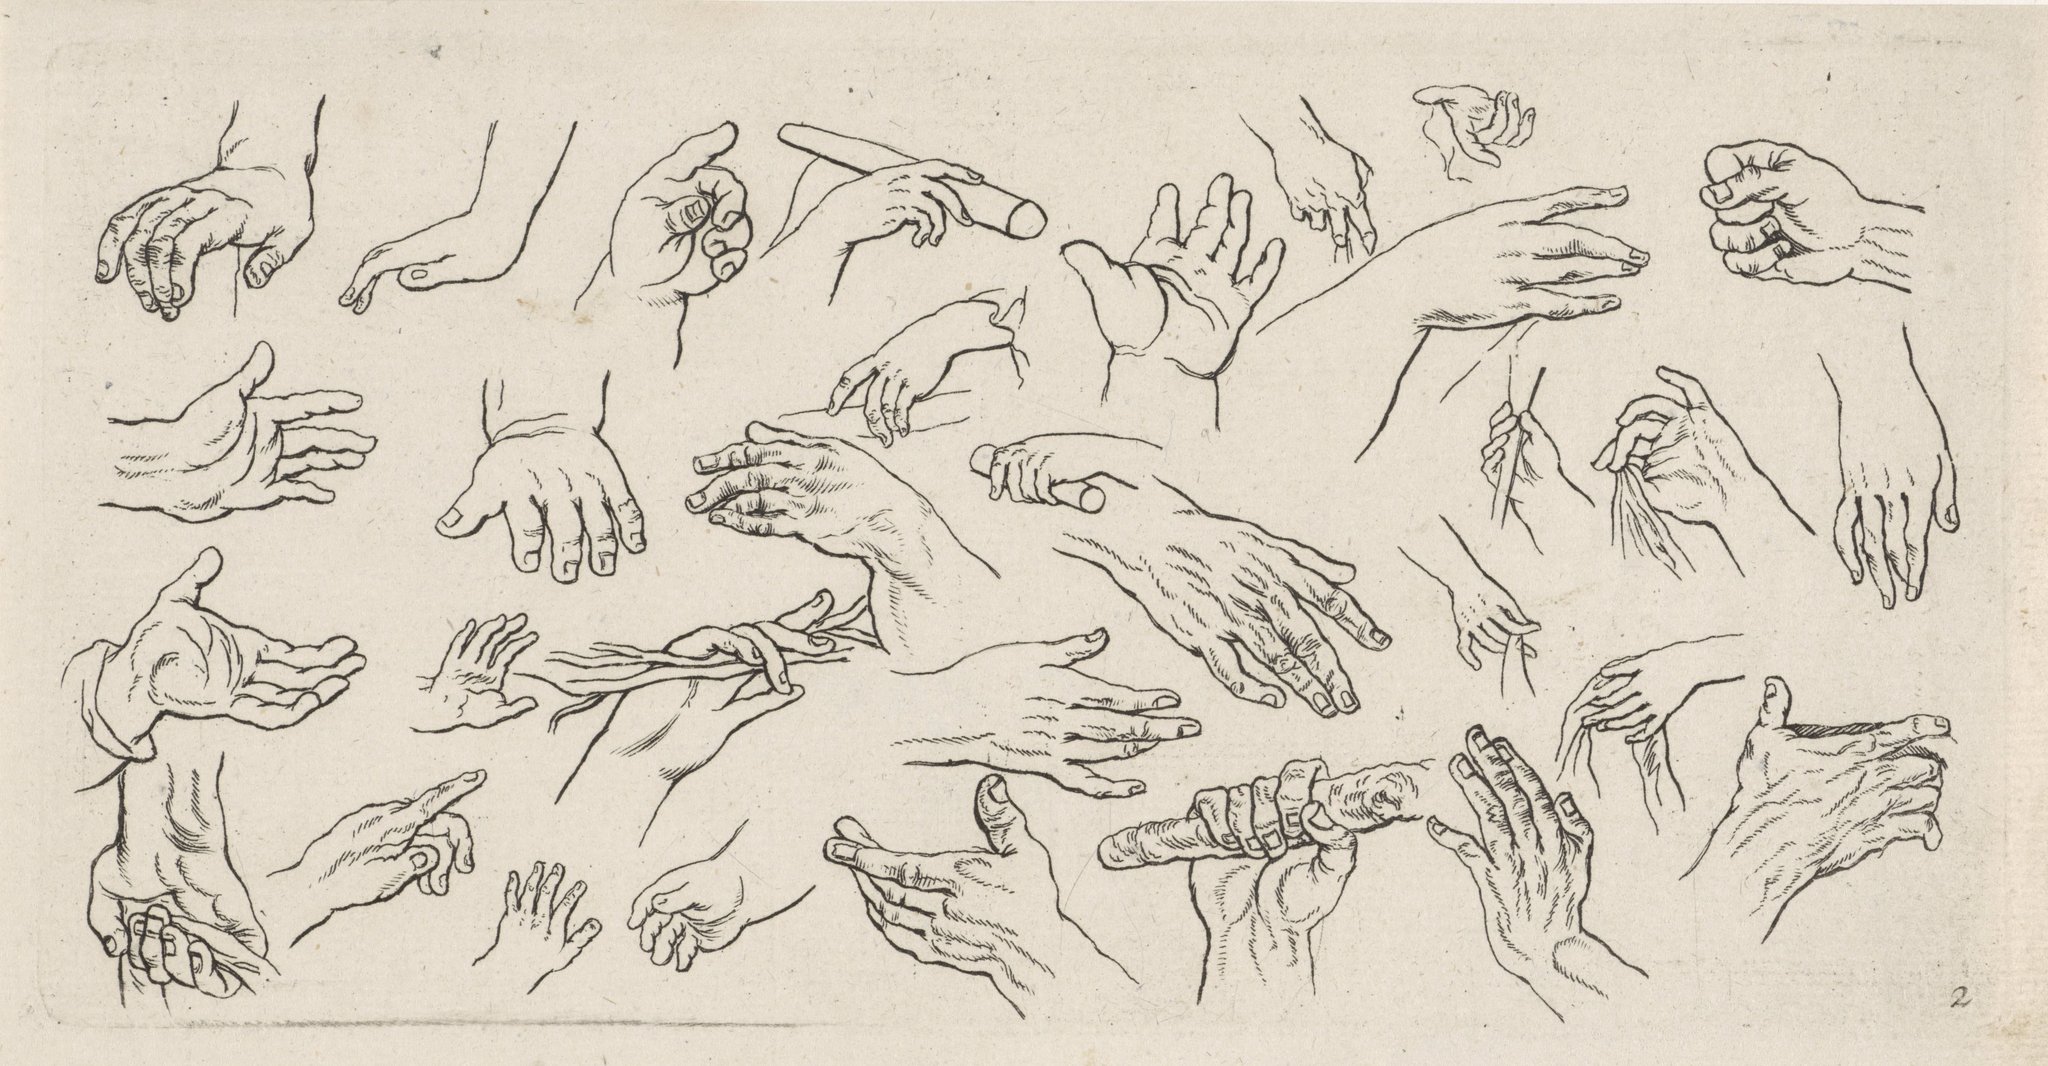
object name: print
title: Studies van menselijke figuren of lichaamsonderdelen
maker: leonard schenk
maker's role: print maker, publisher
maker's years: 1696-1767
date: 1710-1767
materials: paper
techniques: etching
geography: amsterdam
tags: hand, hand made into a fist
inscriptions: collector's mark: Lugt 2228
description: Verschillende aanzichten van de menselijke hand. Sommige handen zijn tot een vuist gebald en andere handen houden een voorwerp vast. De prent is afkomstig uit een serie van vermoedelijk twaalf studievoorbeelden voor jonge kunstenaars.